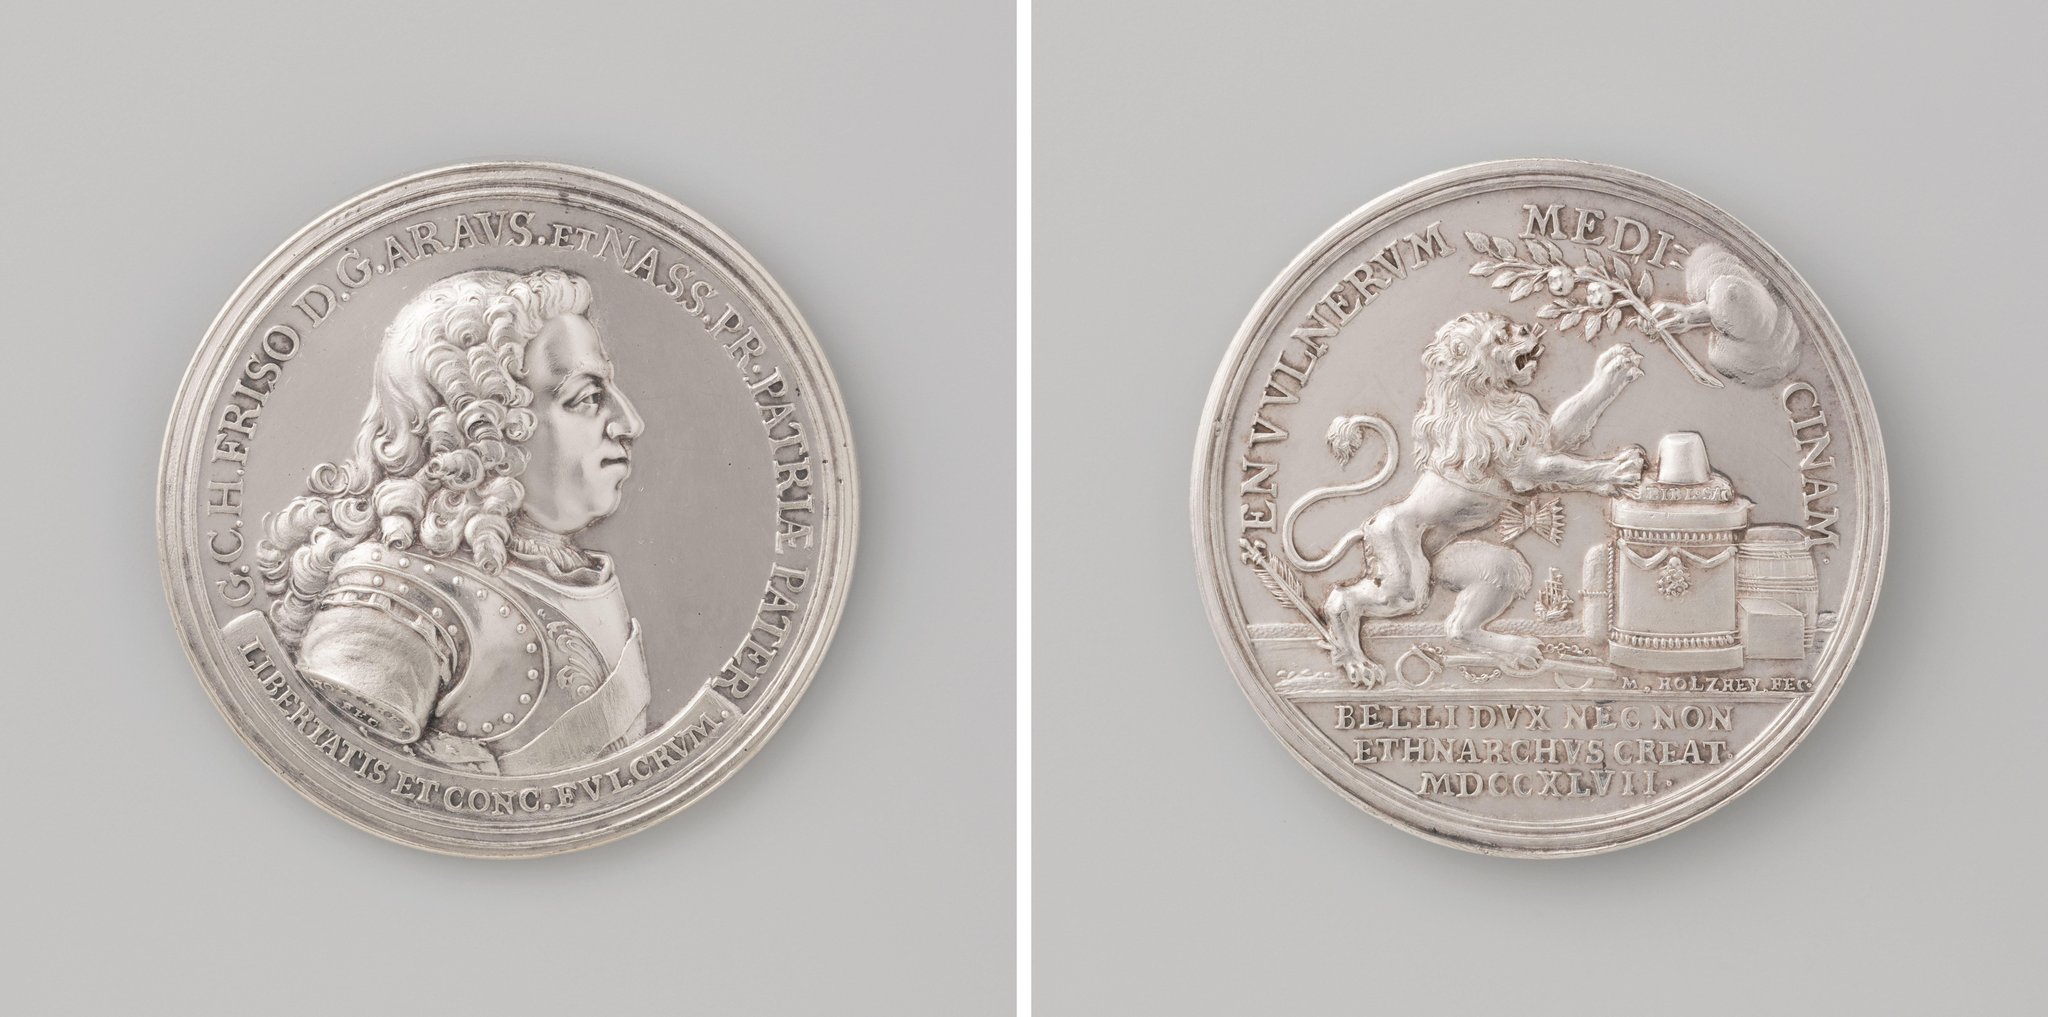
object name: history medal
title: Verheffing van de prins van Oranje tot stadhouder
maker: martinus holtzhey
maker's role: medailleur, muntmaker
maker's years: 1697-1764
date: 1747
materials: silver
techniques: striking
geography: amsterdam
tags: the hague, willem iv (prins van oranje-nassau)